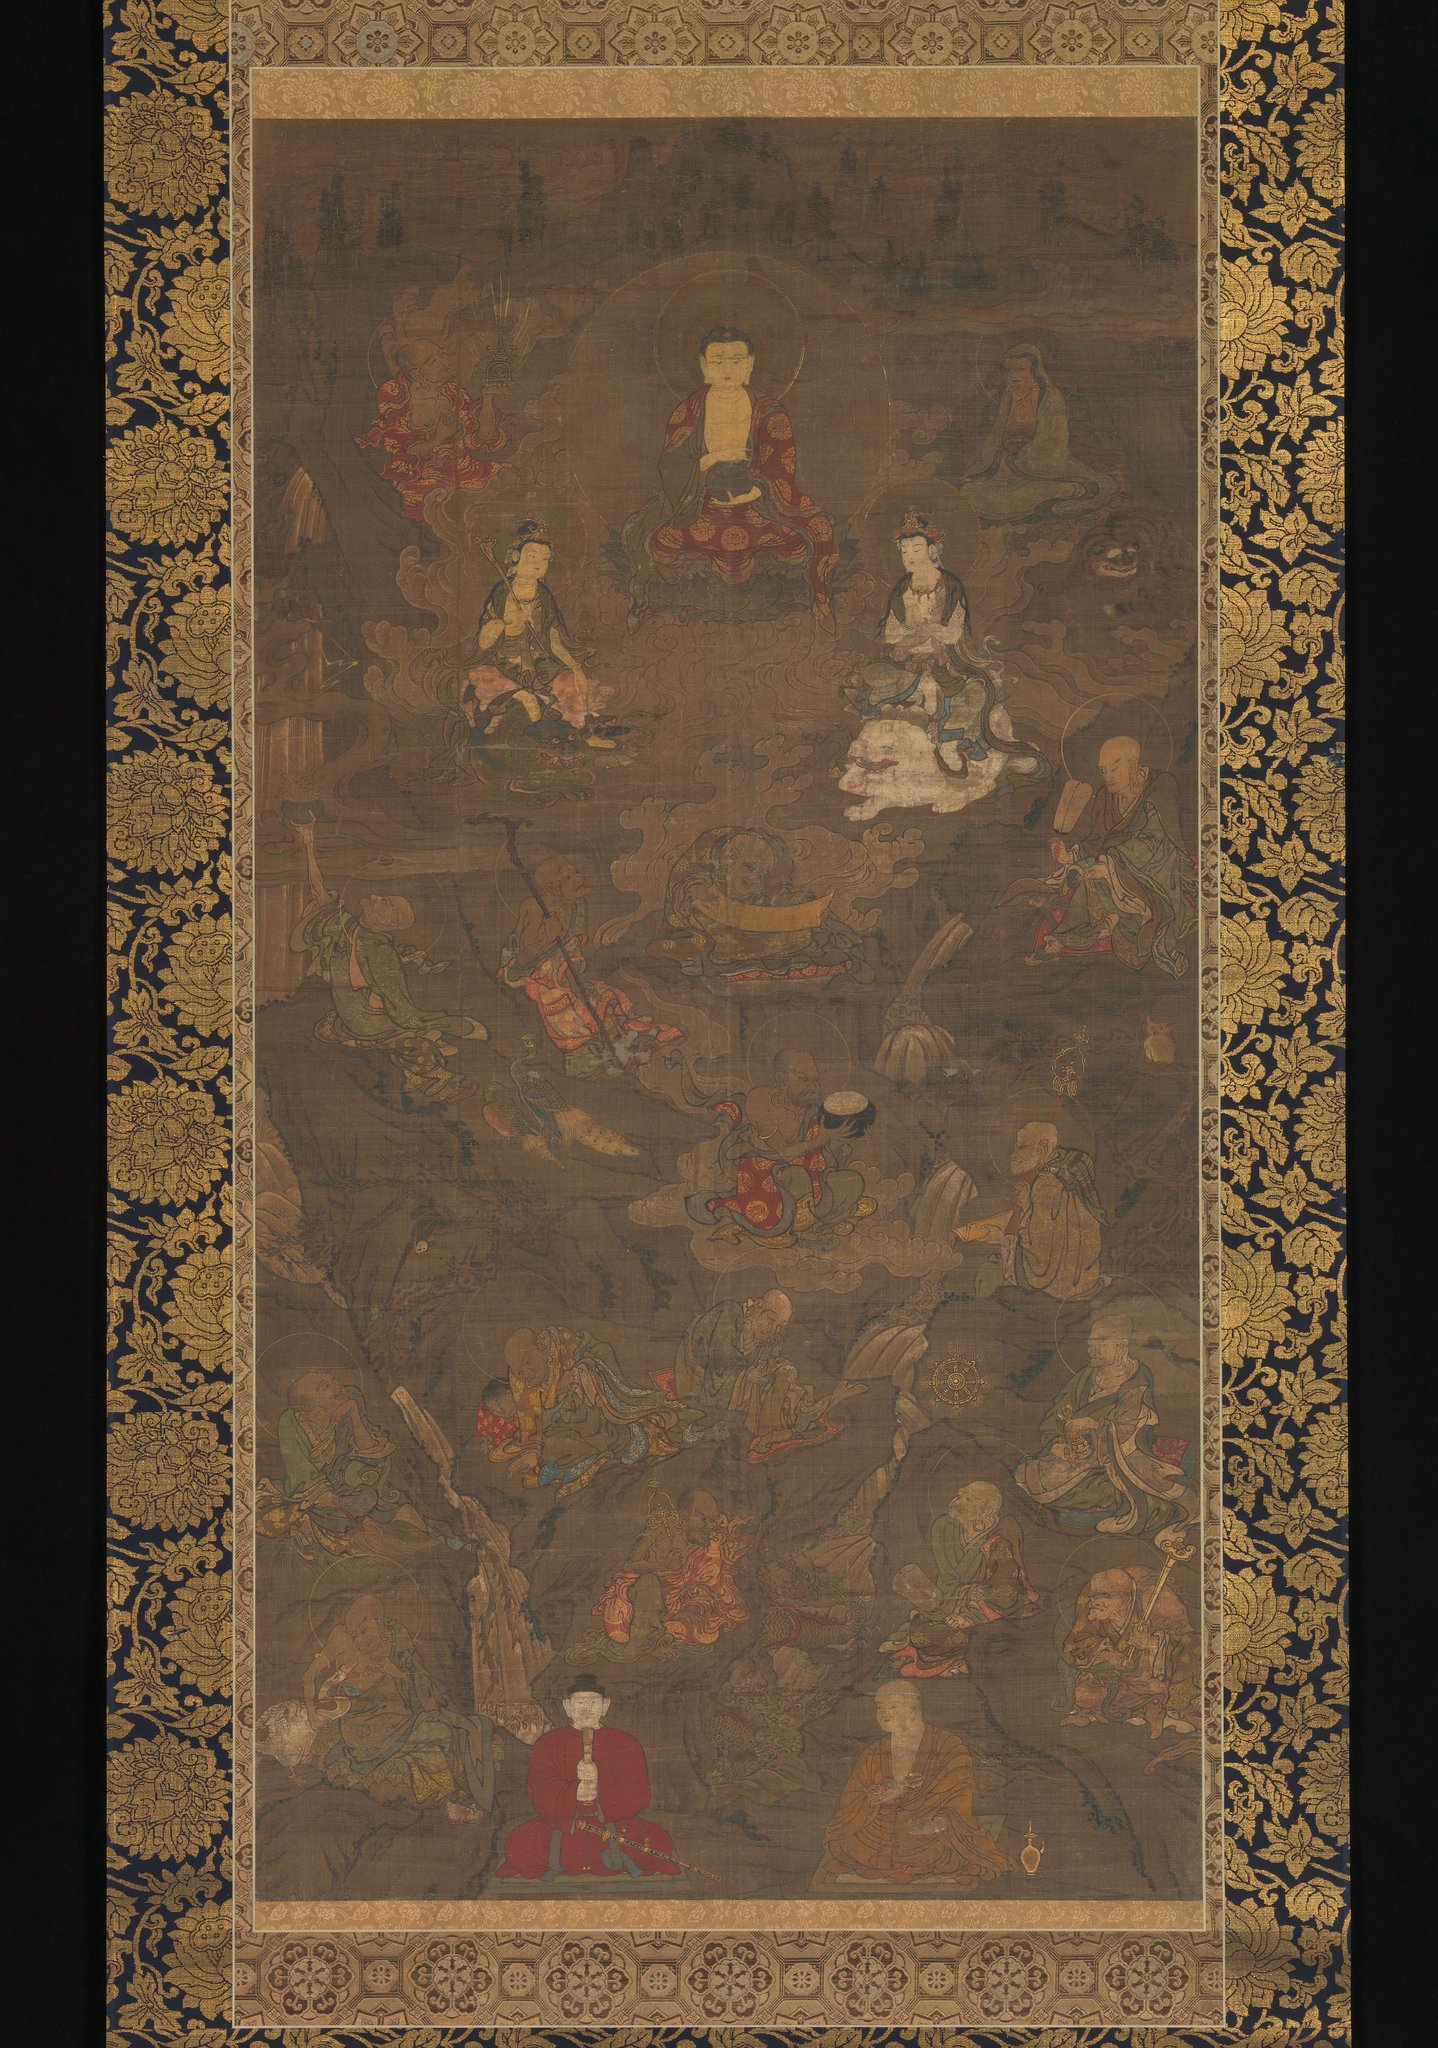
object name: hanging scroll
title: Shaka (Shakyamuni), the Historical Buddha, with Two Attendant Bodhisattvas and Sixteen Arhats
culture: japanese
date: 1301-1400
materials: gold, ink, silk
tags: geese,men,dragons,owls,peacocks,elephants,lions,monkeys,tigers,buddhism,bodhisattvas,buddha